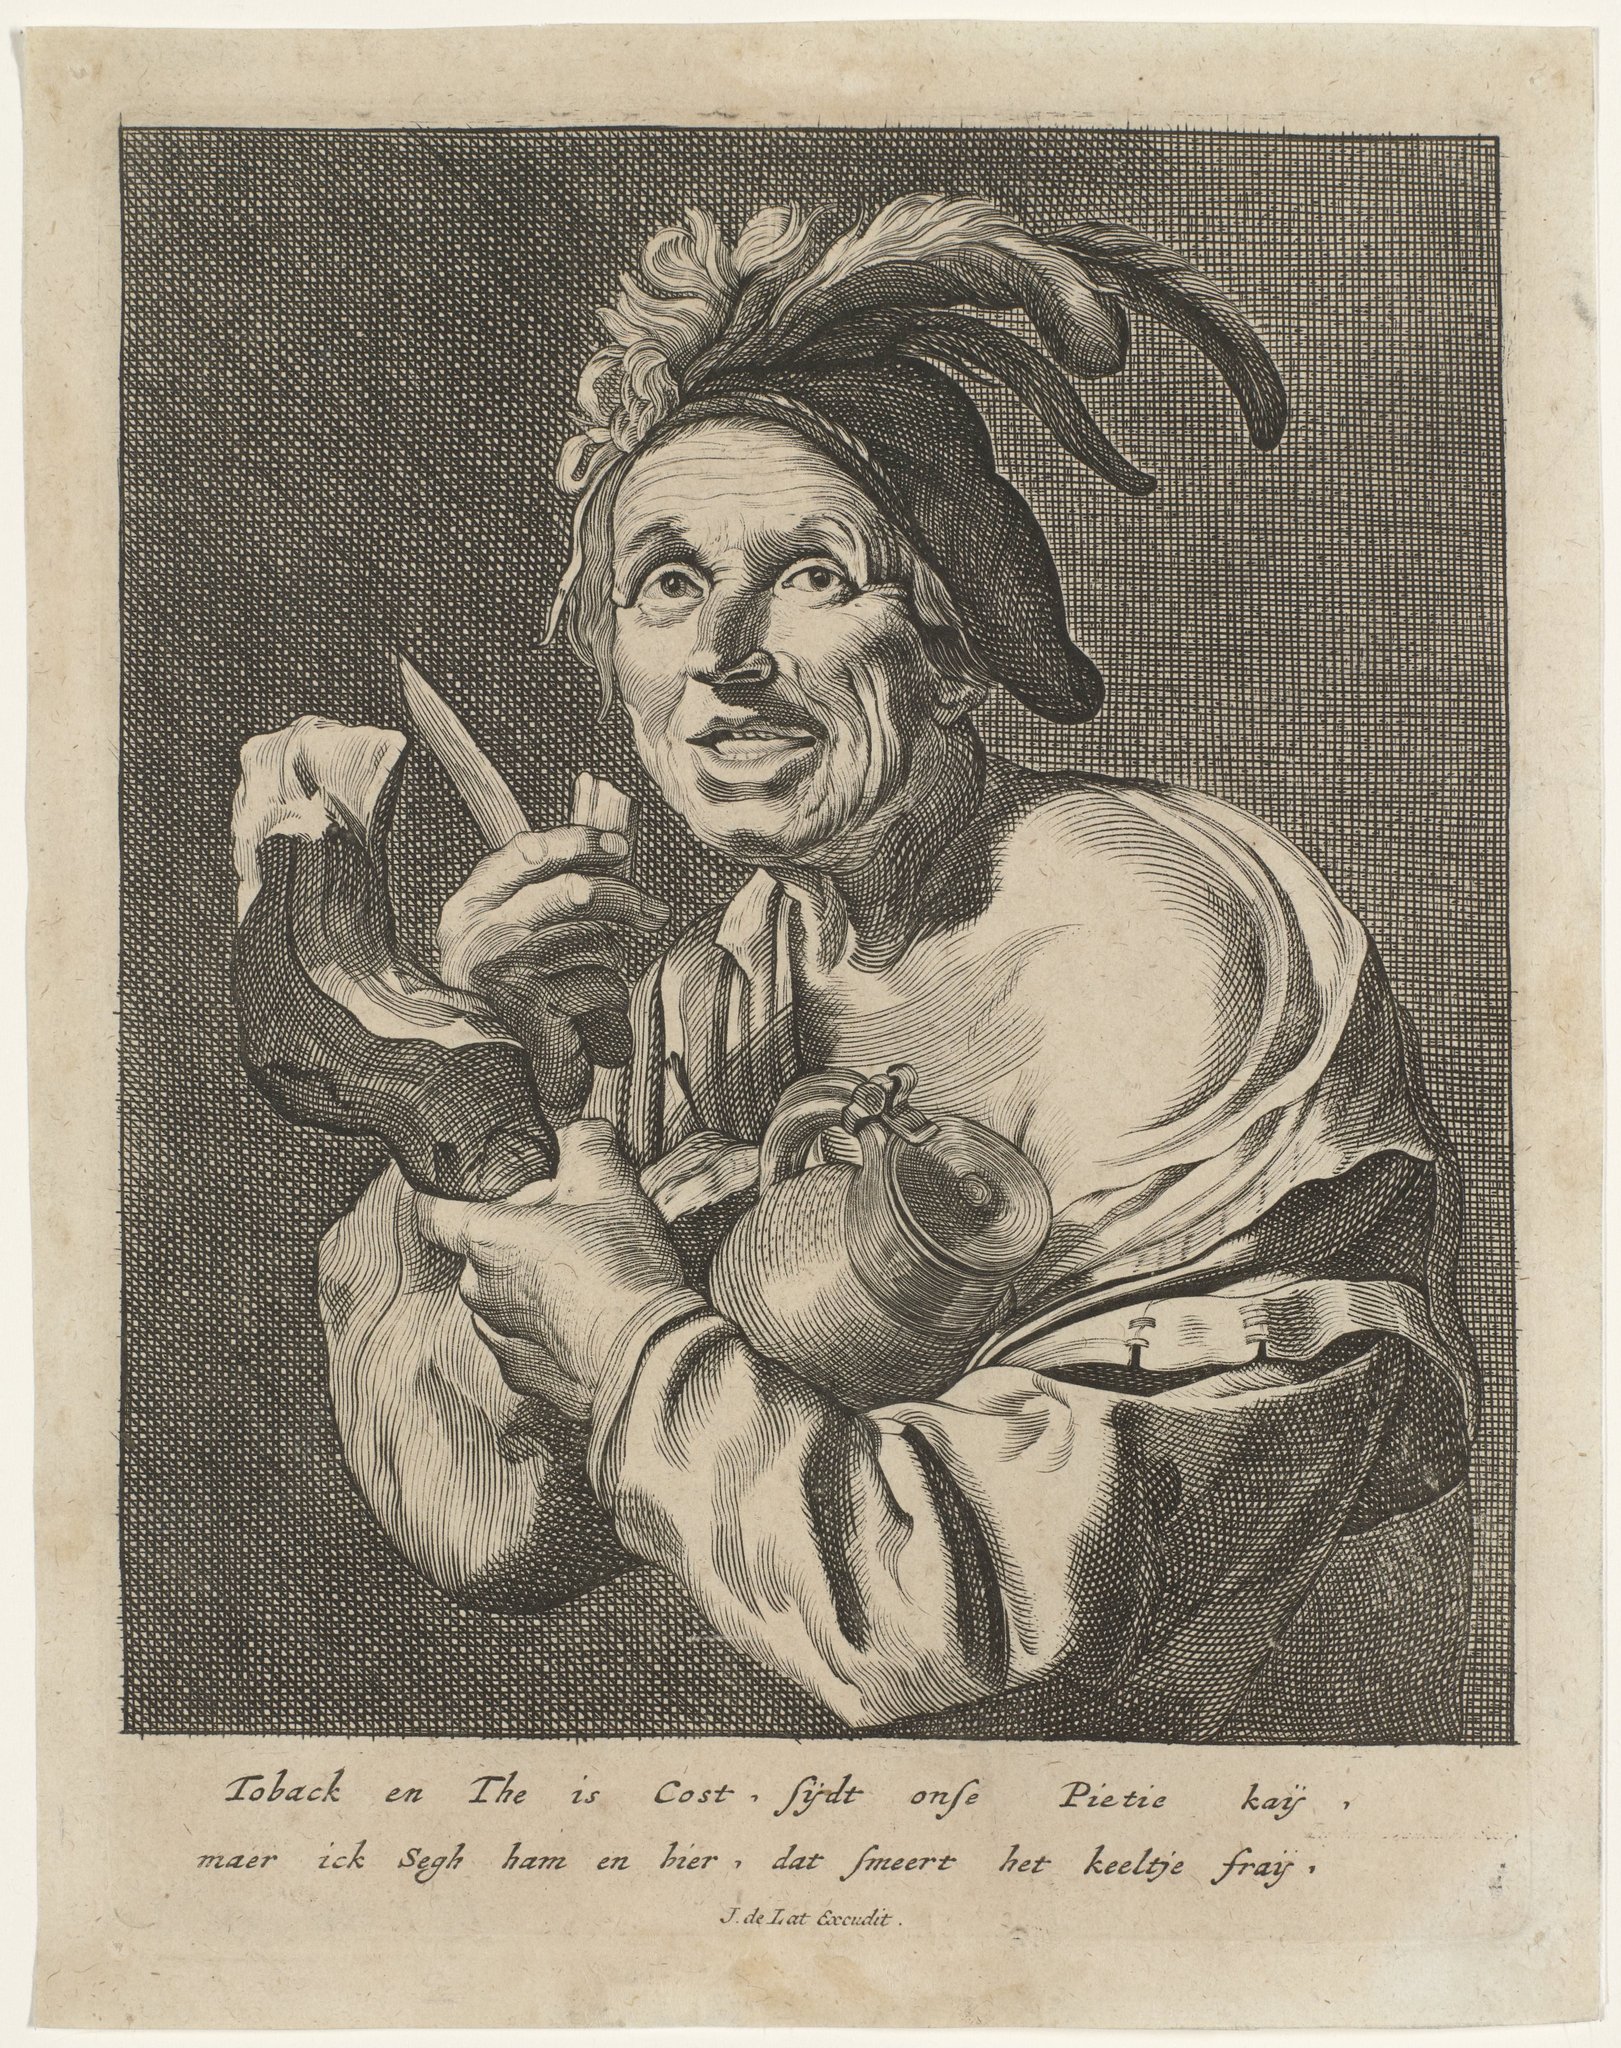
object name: print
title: De hameter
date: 1650-1808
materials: paper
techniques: engraving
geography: europe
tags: jar, jug (used as drinking-vessel), head-gear: hat (+ men's clothes), beer, ale, ham, eating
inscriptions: : ‘Toback en The is Cost, sijdt onse Pietie kaij / maer ick Segh ham en bier, dat smeert het keeltje fraij’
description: Na de overname van de firma Niemeyer door British American Tabacco Group besloot deze de collectie van het Niemeyer Tabaksmuseum af te stoten. De beheerder van de collectie, het Noordelijk Scheepvaartmuseum, organiseerde in januari 2011 open dagen voor musea waar deze hun voorkeuren voor collectieonderdelen kenbaar konden maken. De objecten zijn getaxeerd door medewerkers van Christie's en vervolgens ter overname aangeboden aan de belangstellende musea. Het Rijksprentenkabinet koos 46 prenten uit de collectie tegen door de medewerkers van Christie's vastgestelde waarde. [H. Leeflang, 2011-06-09]. Kopie met ander onderschrift.